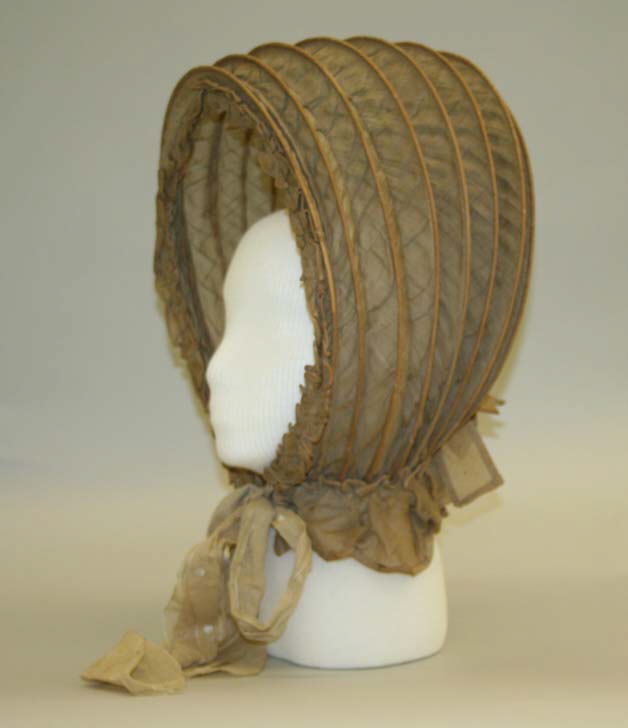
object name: calash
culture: american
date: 1801-1833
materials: cotton, metal